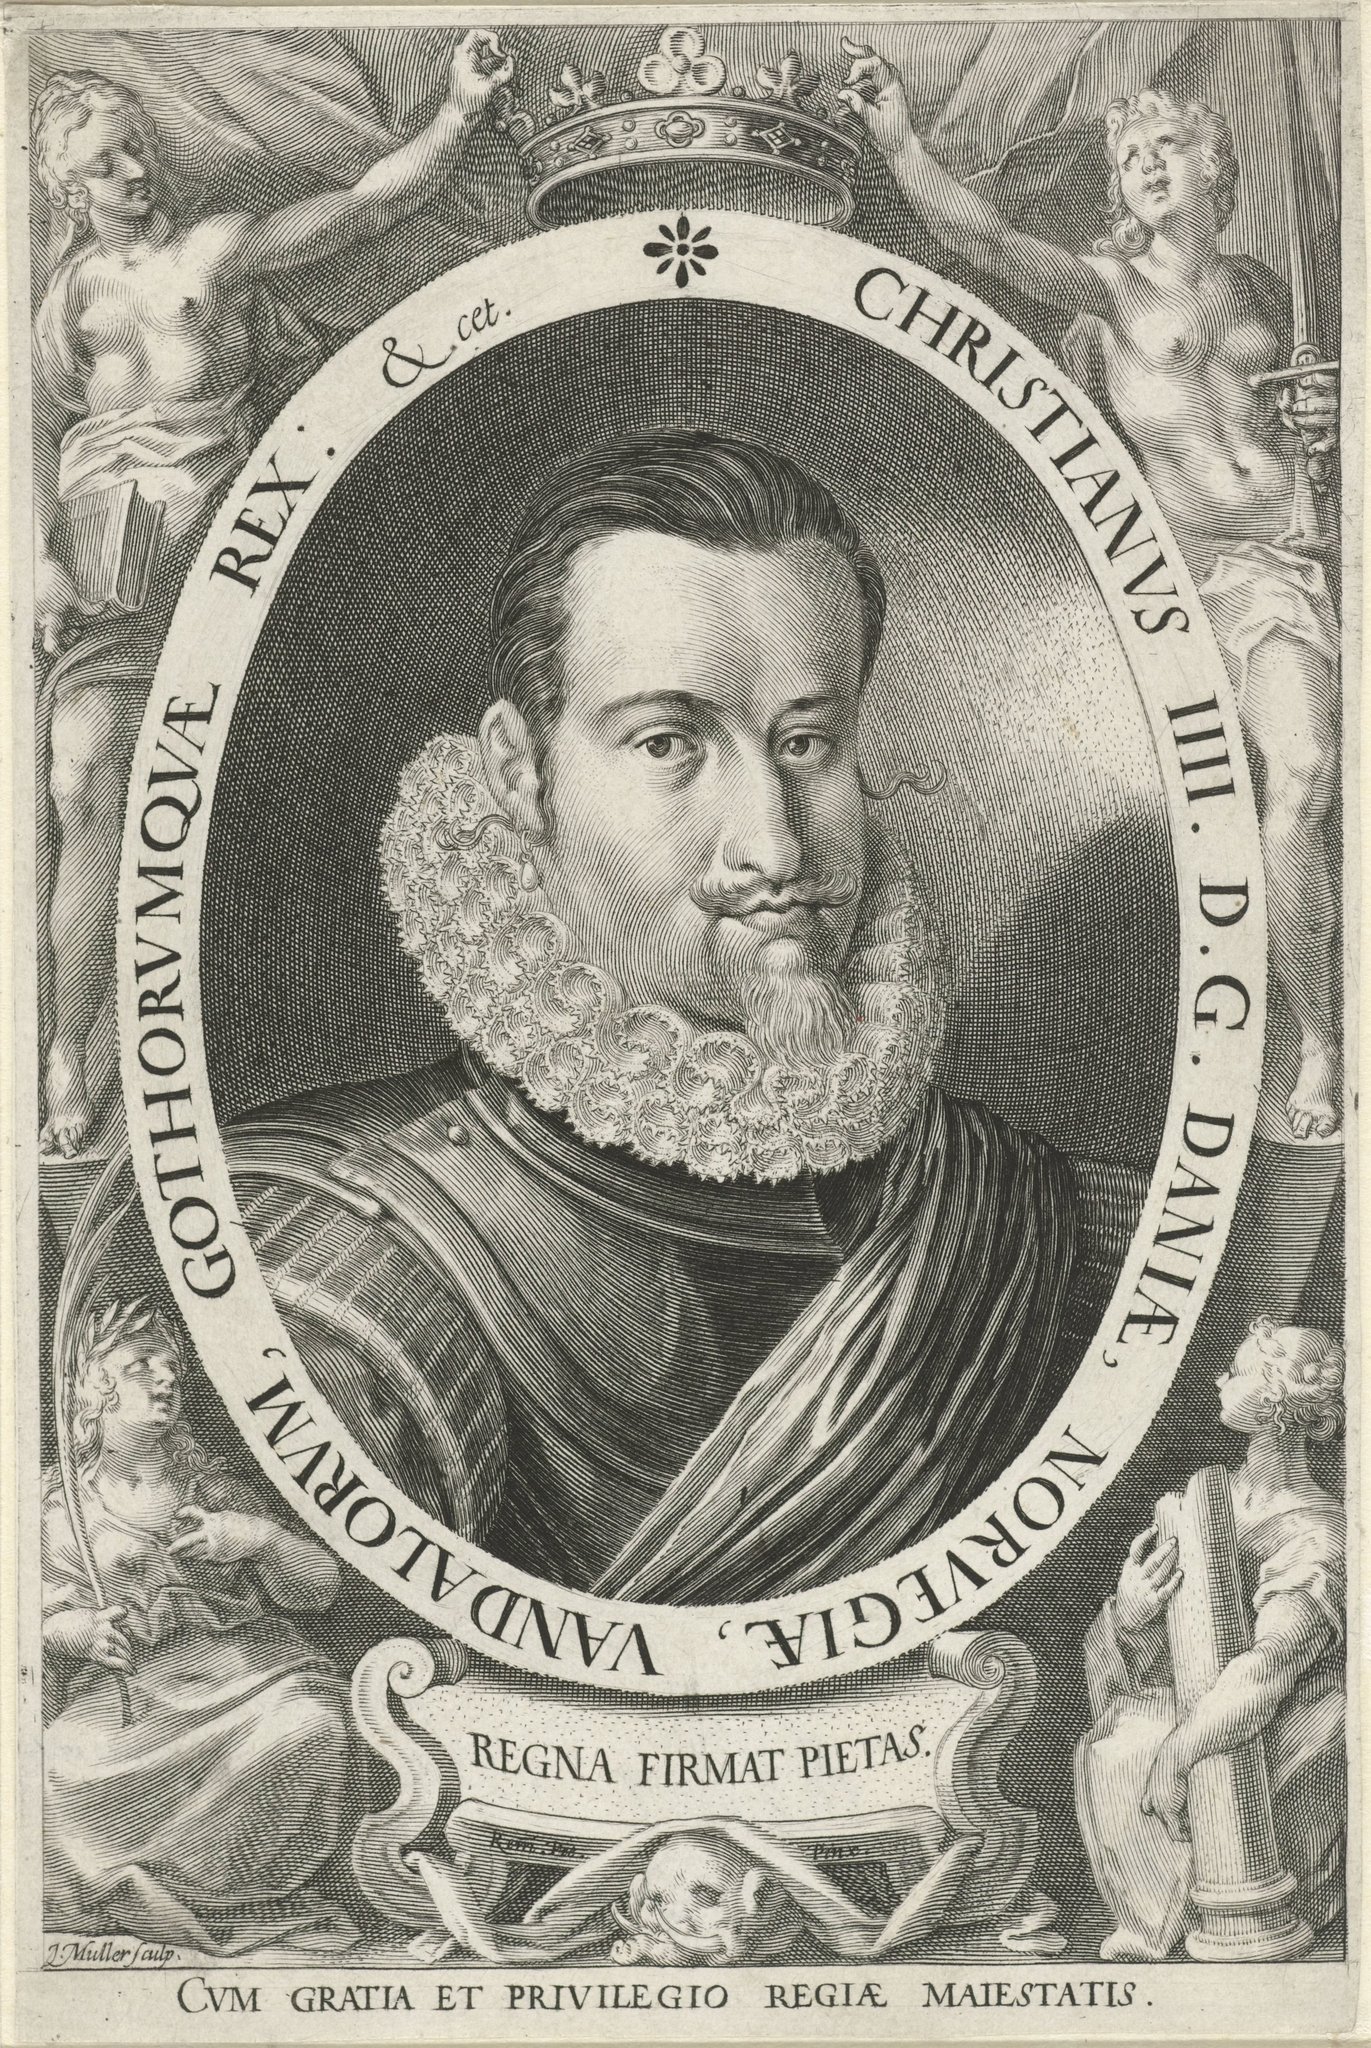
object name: print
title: Portret van koning Christiaan IV van Denemarken en Noorwegen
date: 1604-1608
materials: paper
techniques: engraving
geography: amsterdam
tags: copenhagen (city), christiaan iv (koning van denemarken en noorwegen), fortitude, 'fortitudo' ~ one of the four cardinal virtues, justice, 'justitia'; 'giustitia divina' (ripa) ~ one of the four cardinal virtues, prudence, 'prudentia'; 'prudenza' (ripa) ~ one of the four cardinal virtues, fame; 'fama', 'fama buona', 'fama chiara' (ripa)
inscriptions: collector's mark: Lugt 2228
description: Portret van Christiaan IV, koning van Denemarken en Noorwegen. Het portret wordt gekroond door Voorzichtigheid en Rechtvaardigheid. Onder in de omlijsting Faam met palmtak en Kracht met een zuil in haar armen.